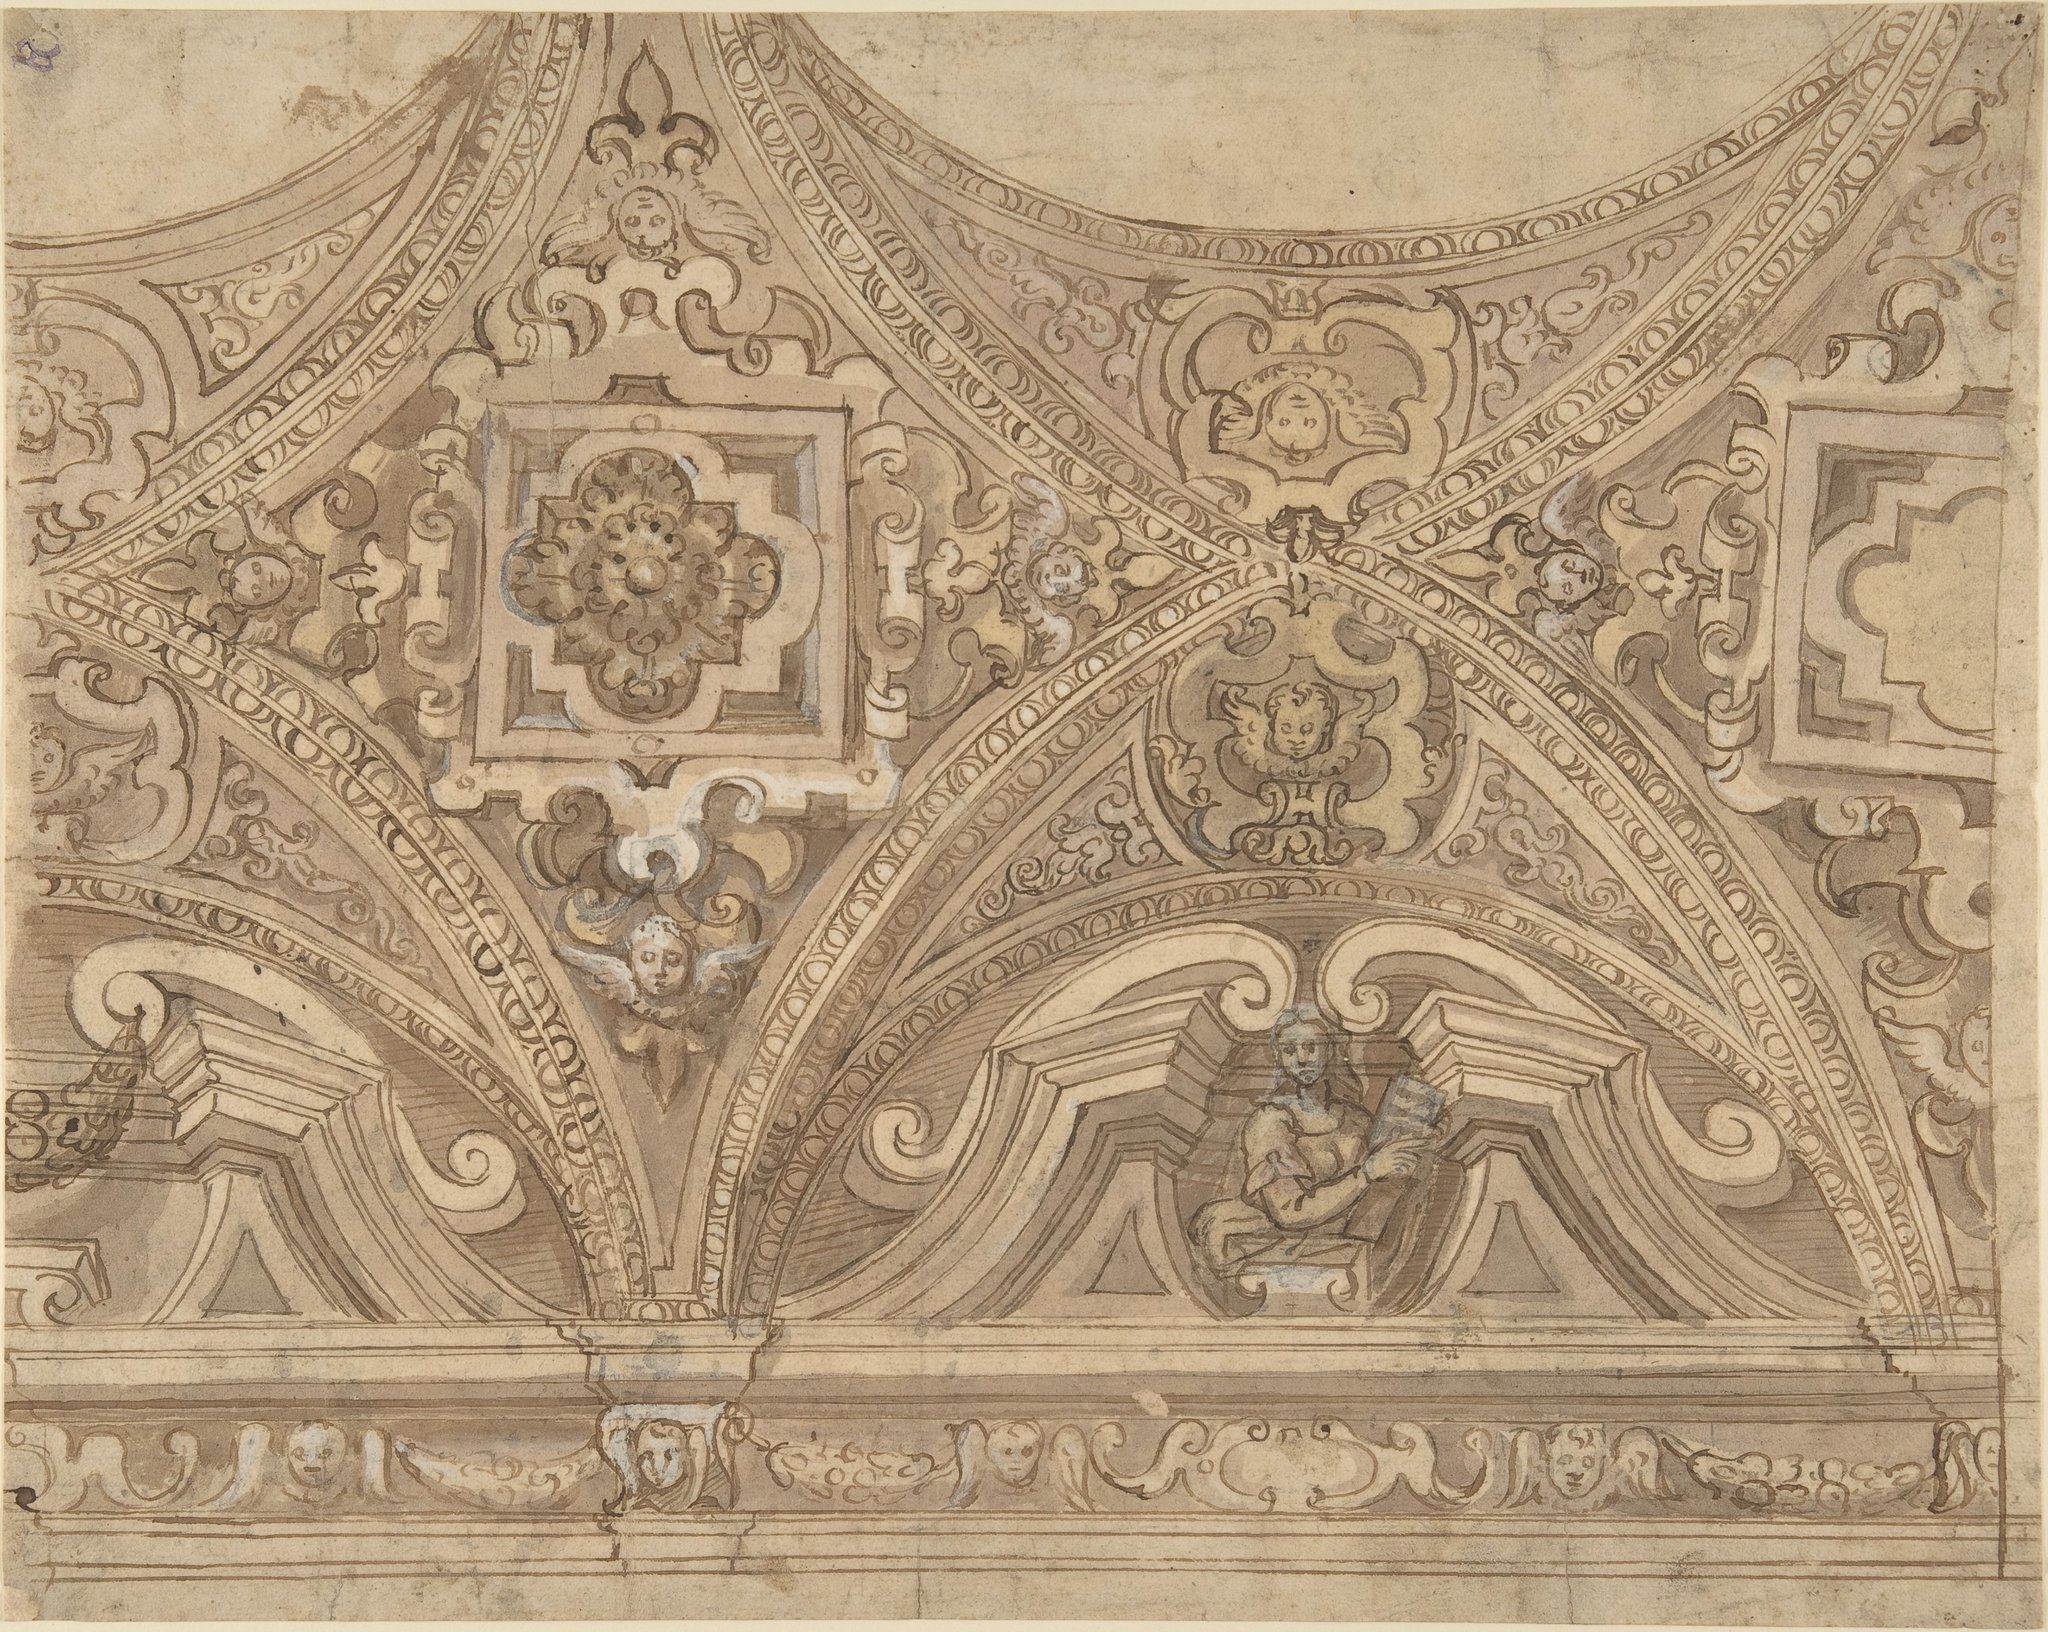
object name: drawing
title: Design for part of a Vaulted Ceiling of a Church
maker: anonymous, italian, 17th century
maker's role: artist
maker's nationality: italian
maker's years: 1600-1700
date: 1601-1700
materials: gouache, ink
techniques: brush, highlighting, pen, wash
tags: women